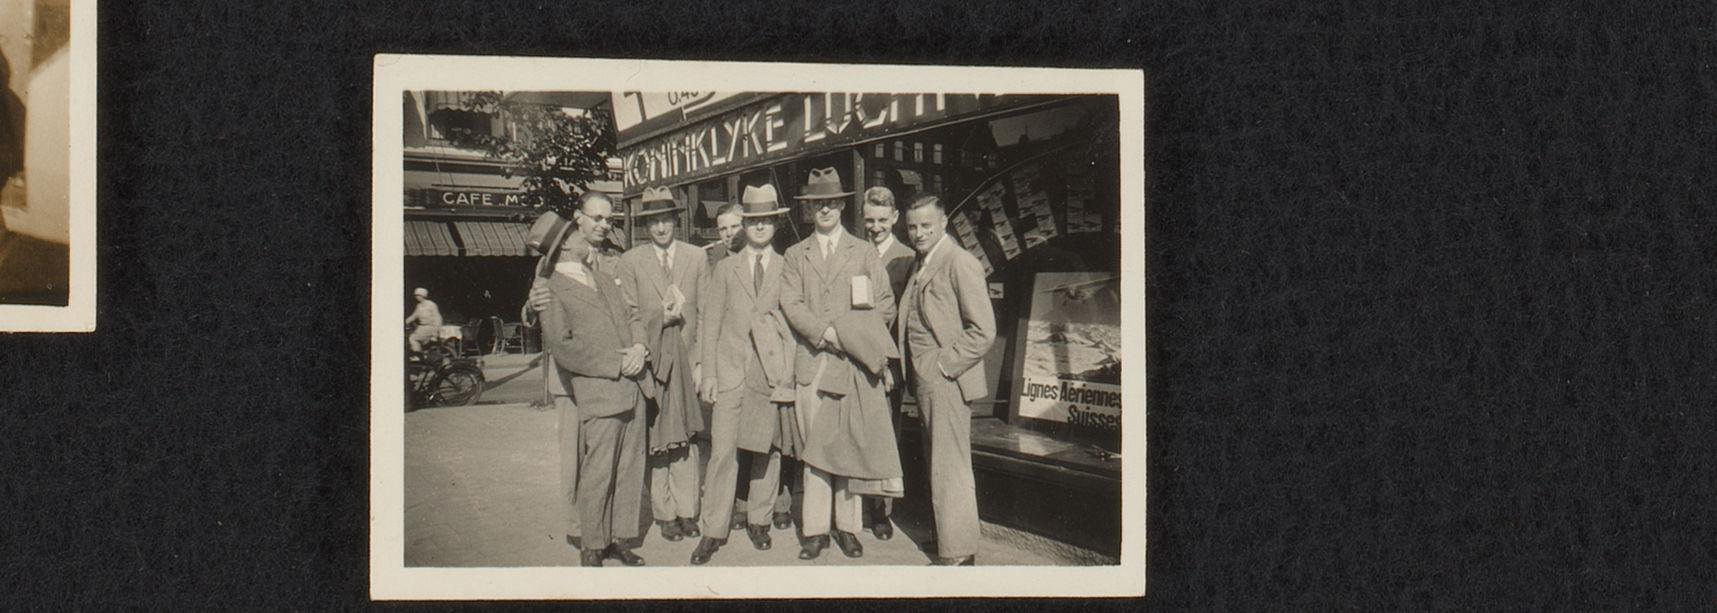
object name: photograph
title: Groep mannen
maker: Anonymous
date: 1930-1950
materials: photographic support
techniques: gelatin silver print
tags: anonymous historical persons portrayed in a group, in a group-portrait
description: Portret van een groep mannen op straat. In envelop met losse foto's behorend bij het fotoalbum over de bewoners van het huis aan de Reguliersgracht te Amsterdam in de periode 1924-1932.